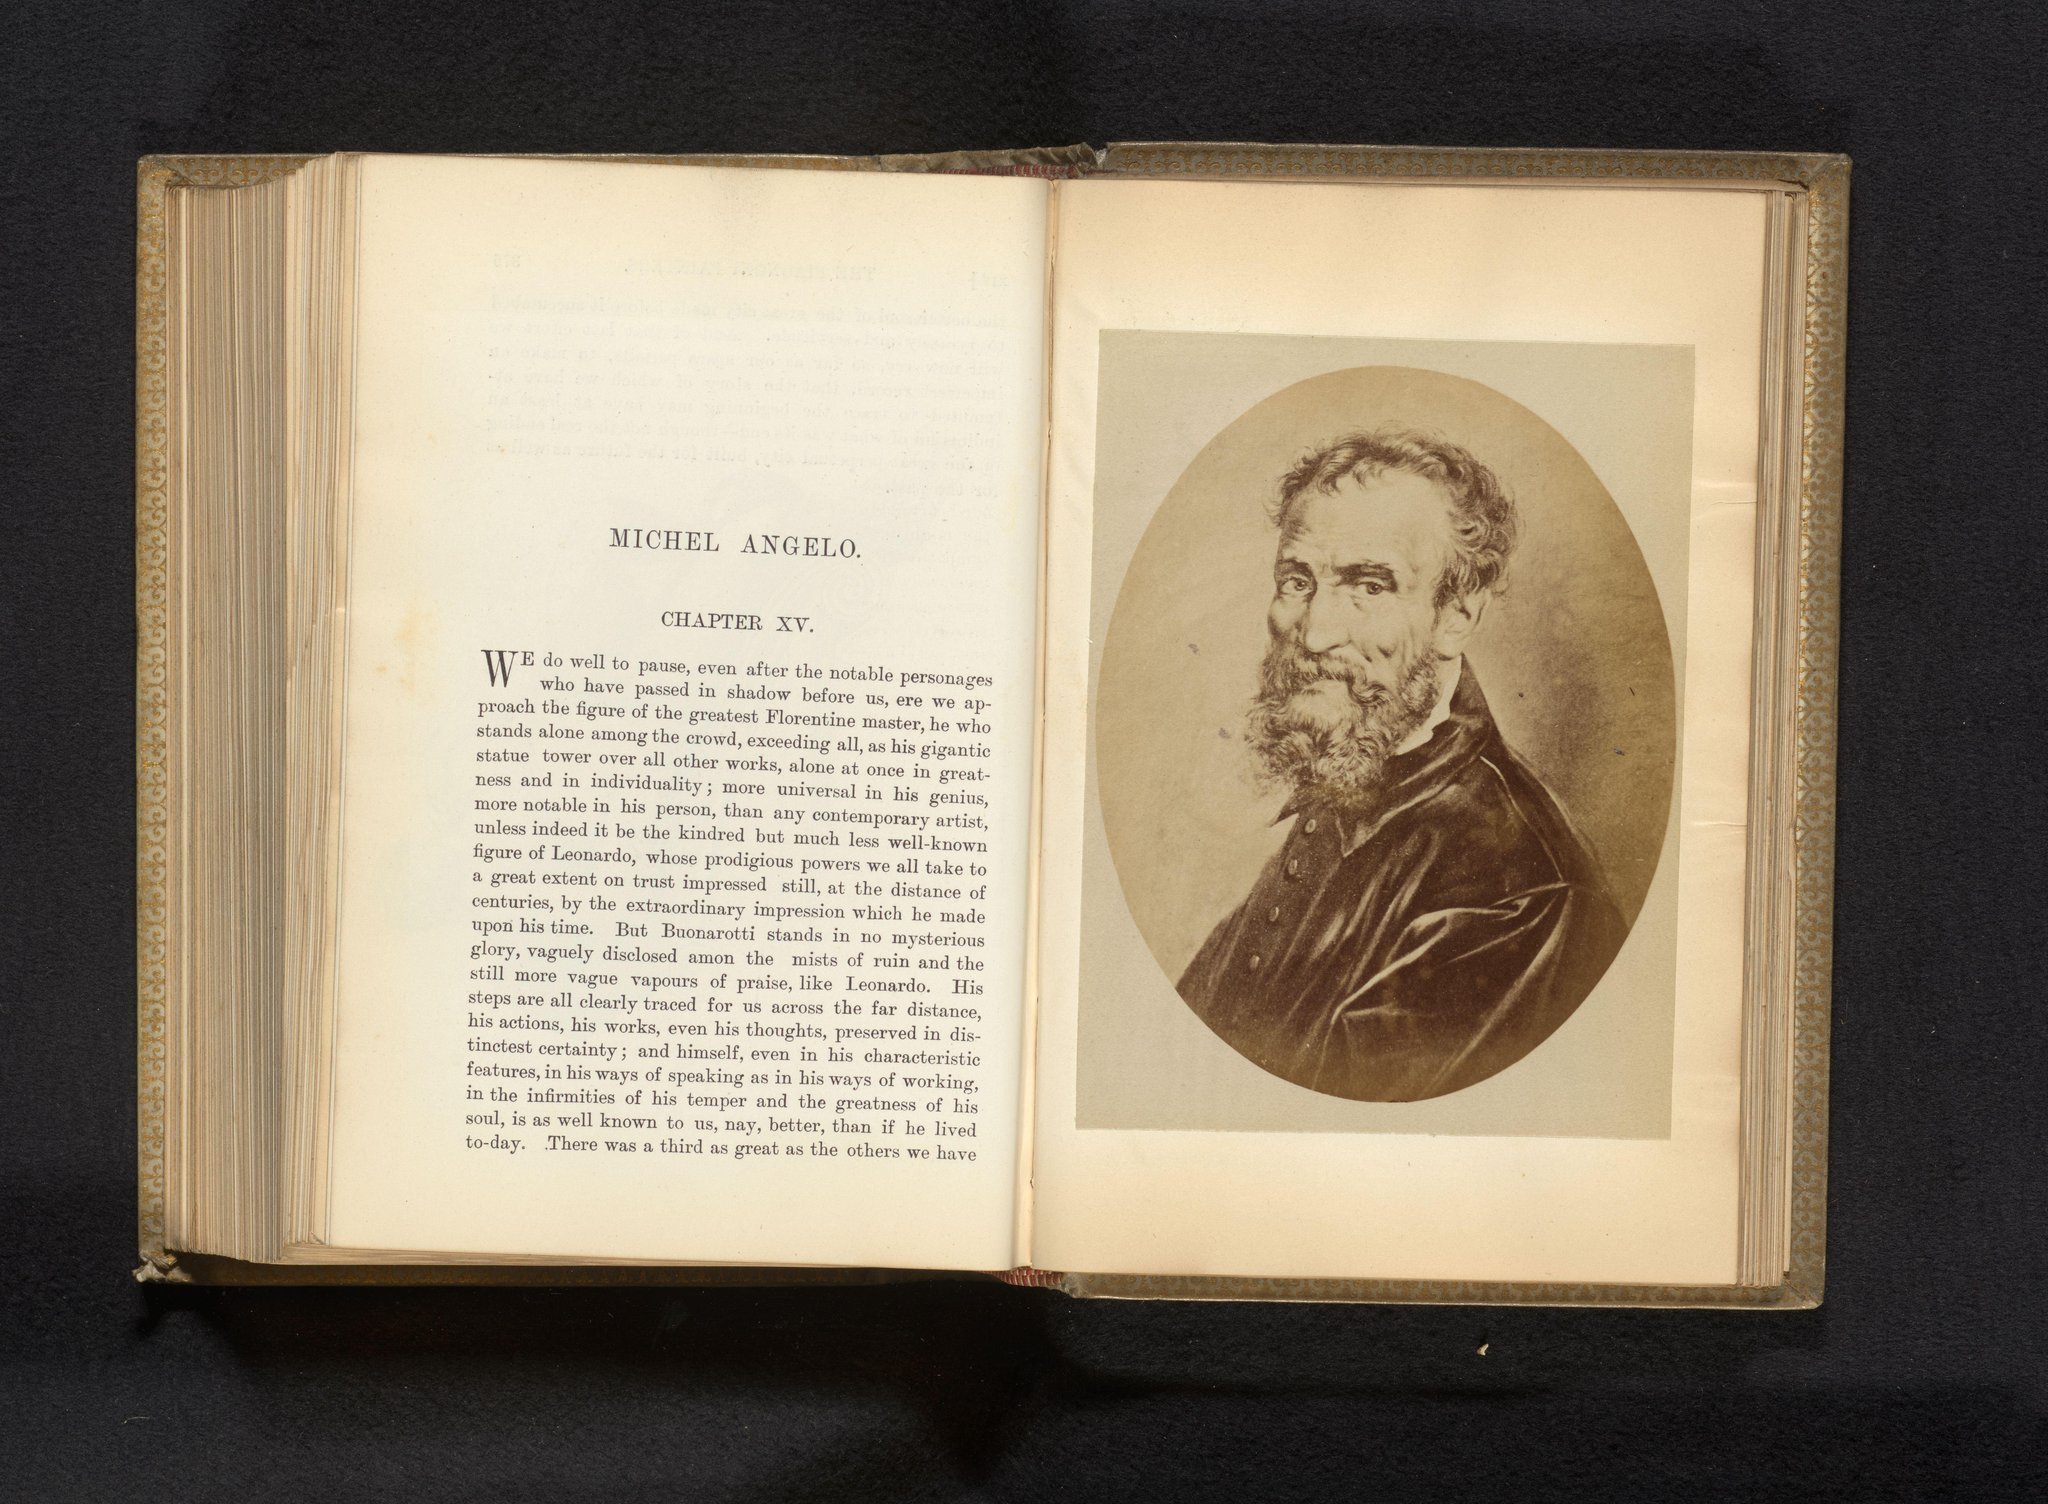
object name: photograph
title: Fotoreproductie van een schilderij, voorstellende een zelfportret van Michelangelo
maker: Anonymous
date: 1878-1888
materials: photographic support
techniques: albumen print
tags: rome, painter, draughtsman, sculptor, michelangelo, portrait, self-portrait of painter